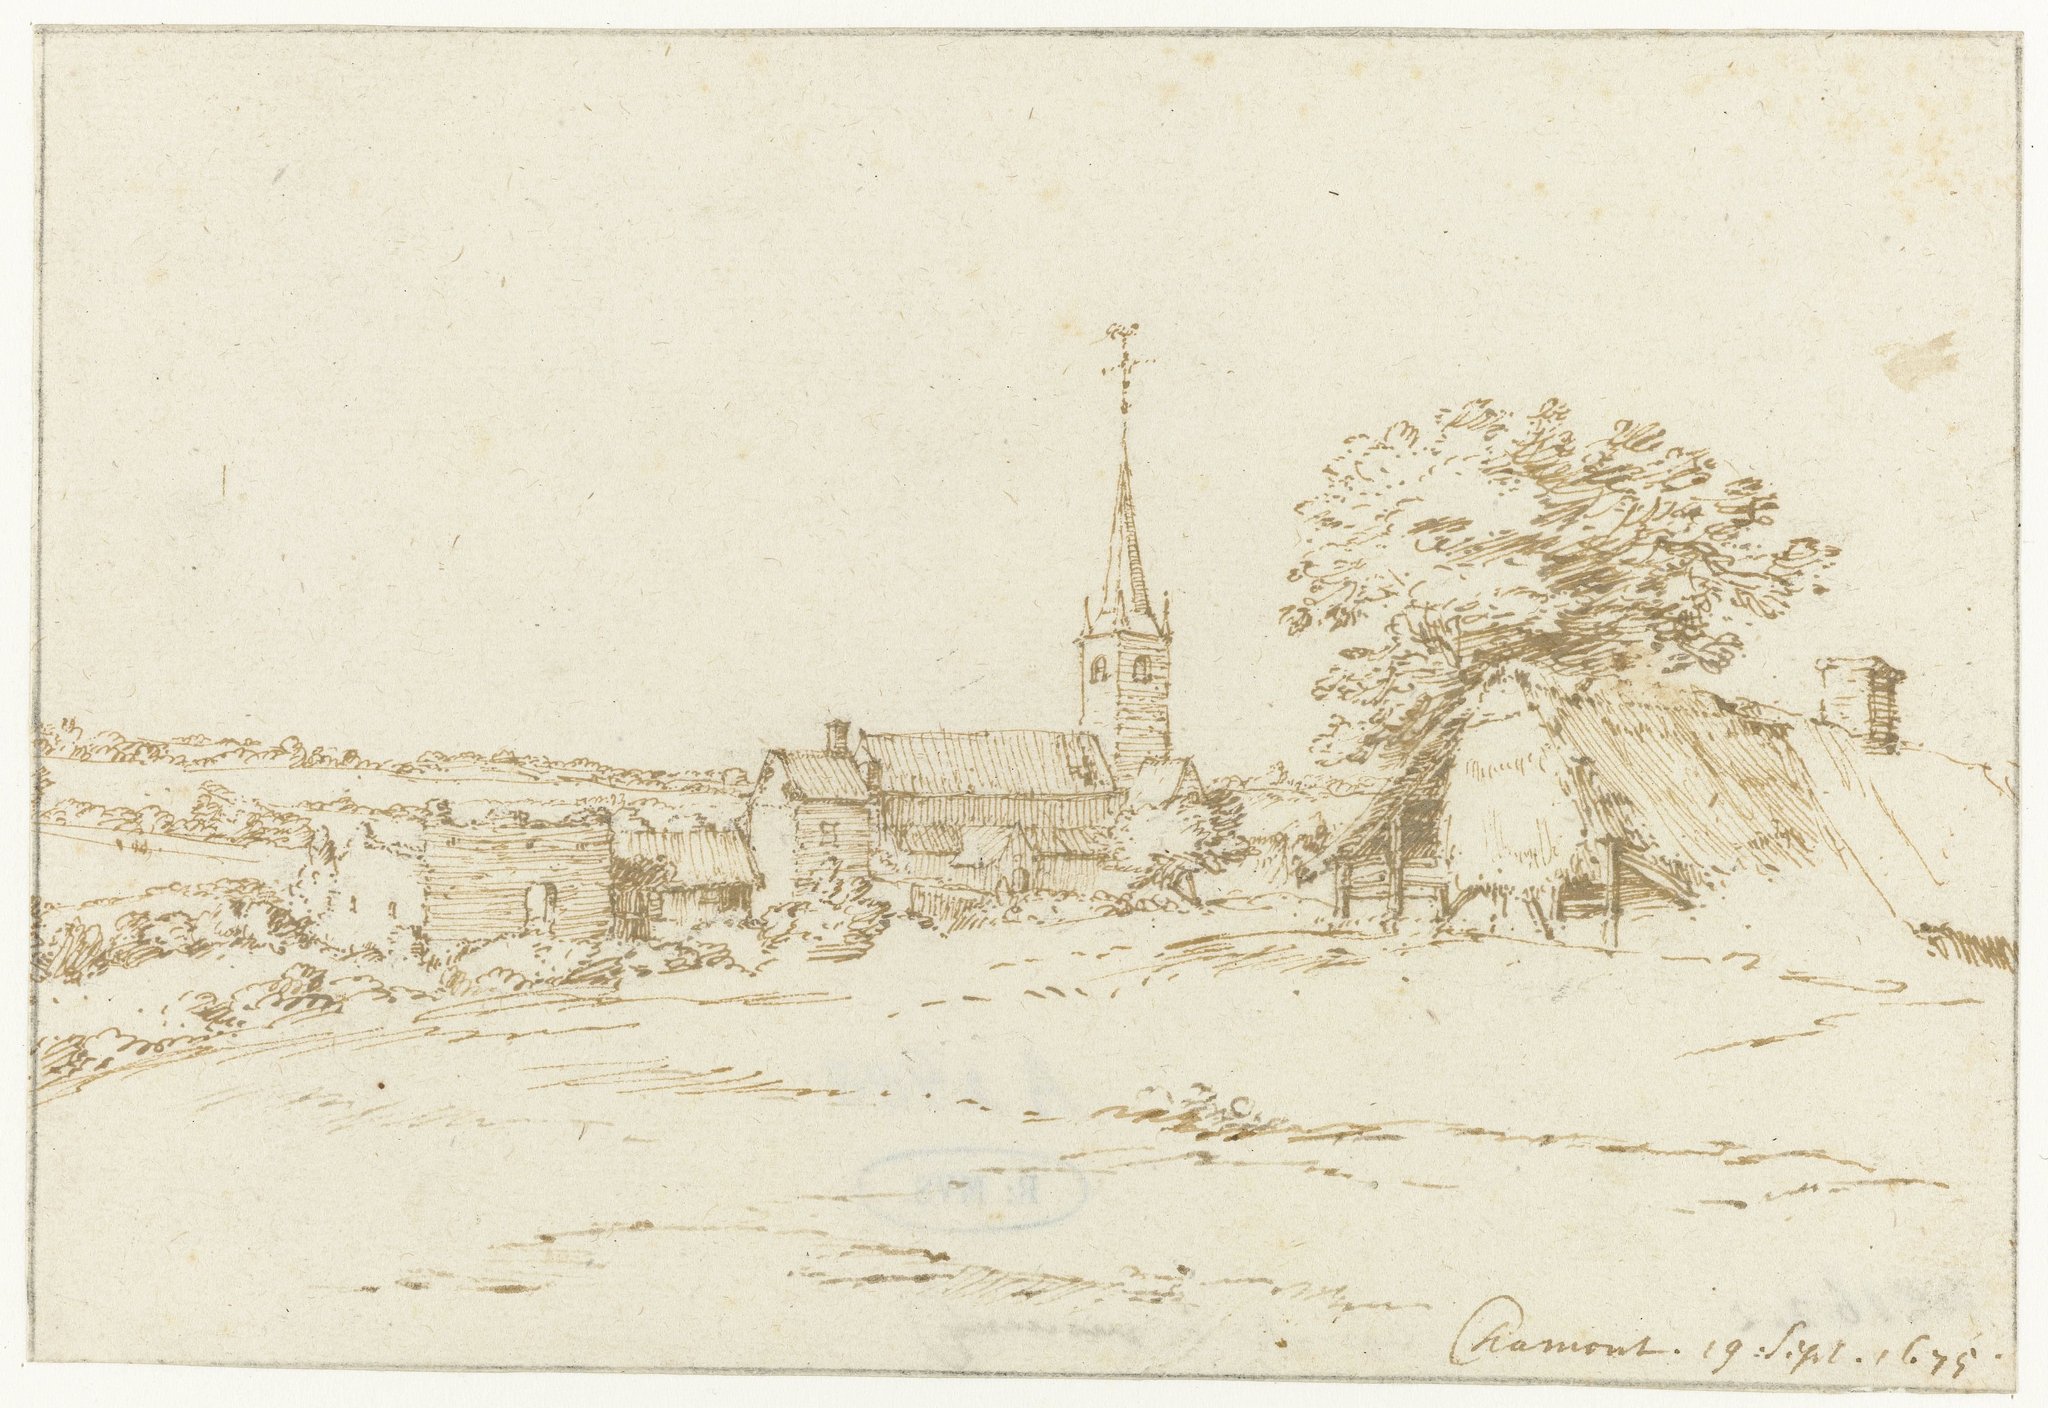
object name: drawing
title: Chaumont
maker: constantijn huygens (ii)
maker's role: draughtsman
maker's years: 1628-1697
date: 1675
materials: ink, paper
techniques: pen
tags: prospect of village, silhouette of village, church (exterior)